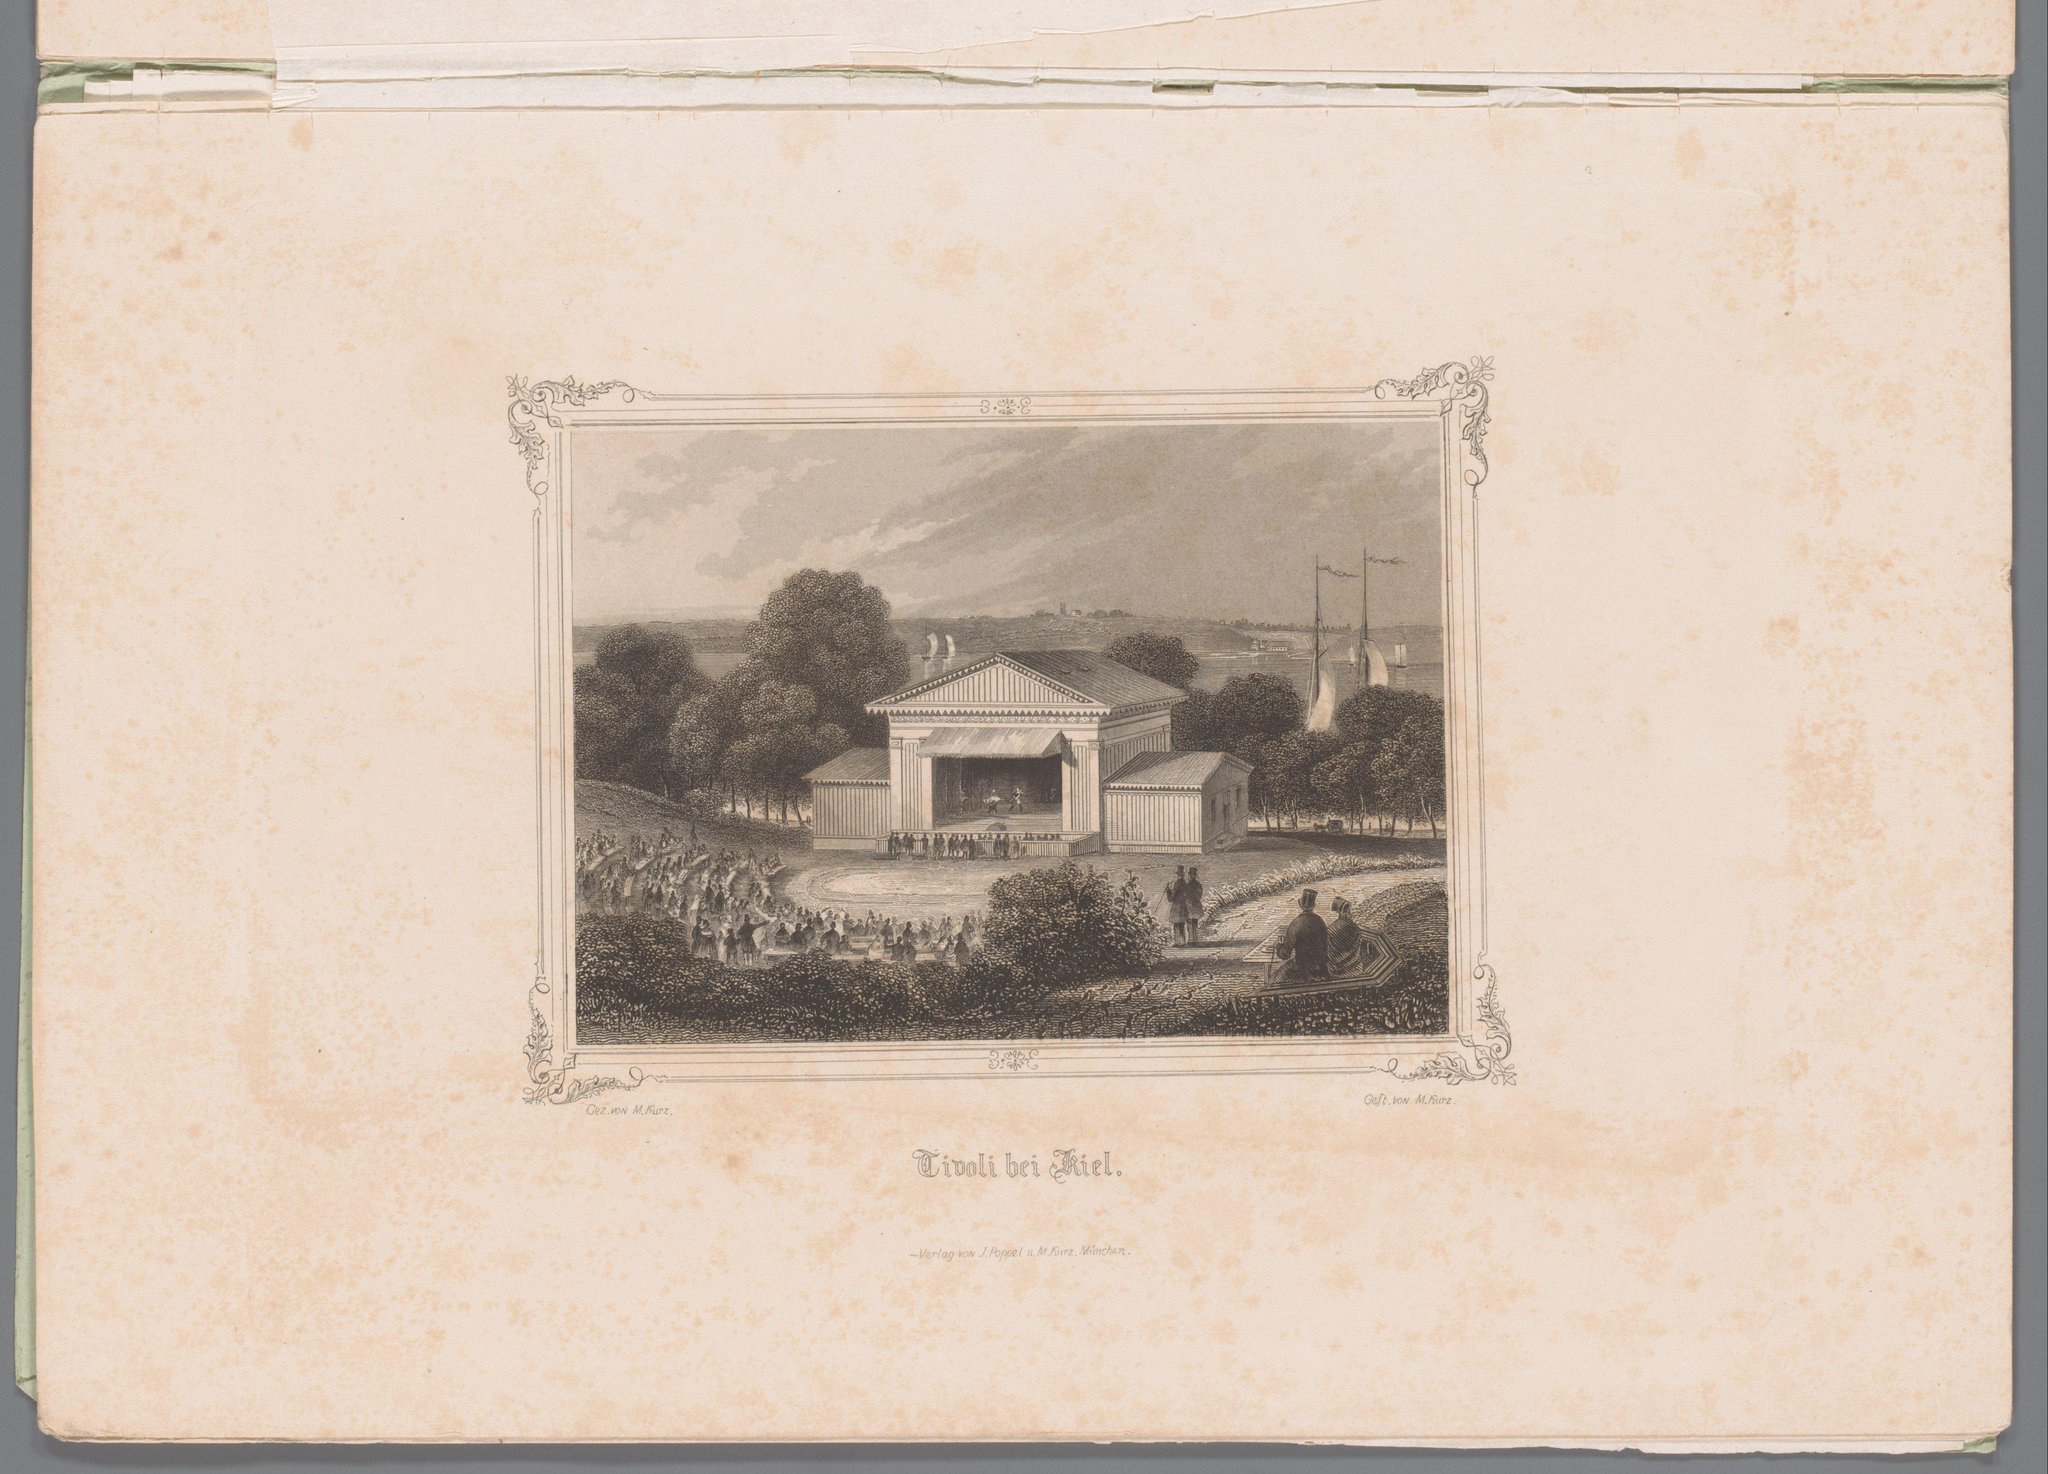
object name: print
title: Landschappen in Sleeswijk-Holstein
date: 1847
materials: paper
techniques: engraving, etching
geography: munich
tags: group of actors, troupe; actors on the stage, galleries ~ theatre, etc. - aa - open-air performances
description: Deze prent behoort tot deel drie of vier van de serie 'Landschappen in Sleeswijk-Holstein'. Het betreft een vierdelige reeks uitgegeven in twee omslagen waarvan deze omslag deel drie en vier bevat met daarin zes landschappen en zes tekstbladen.